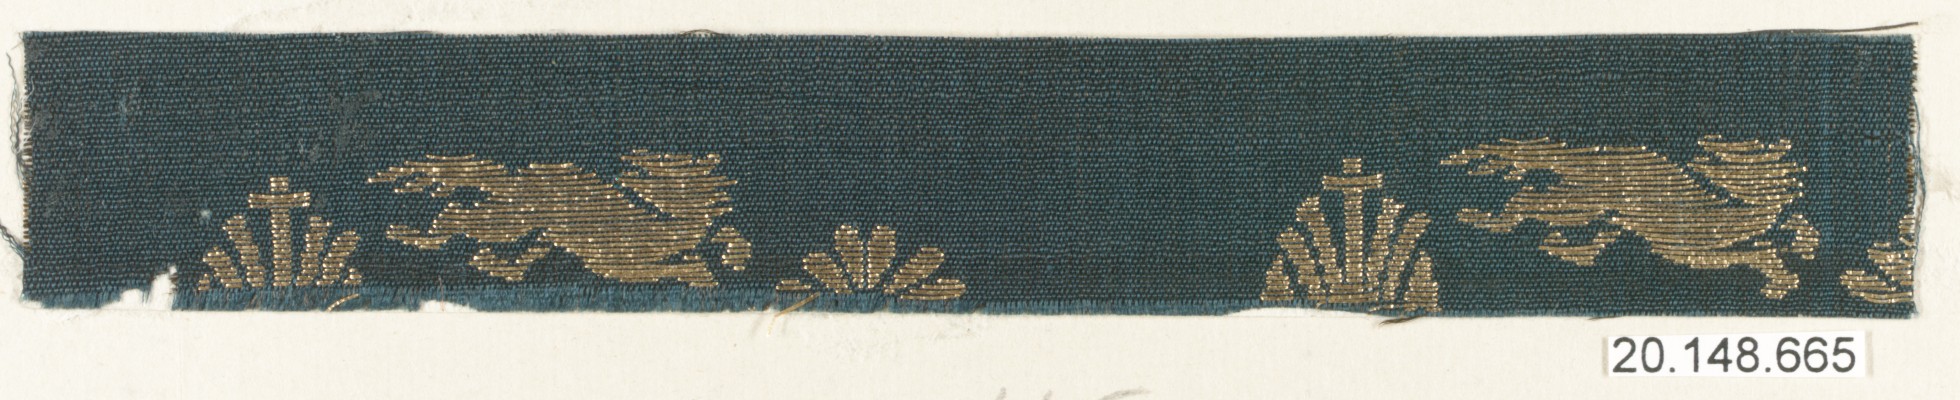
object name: piece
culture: japanese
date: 1701-1800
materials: silk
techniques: compound weave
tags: animals